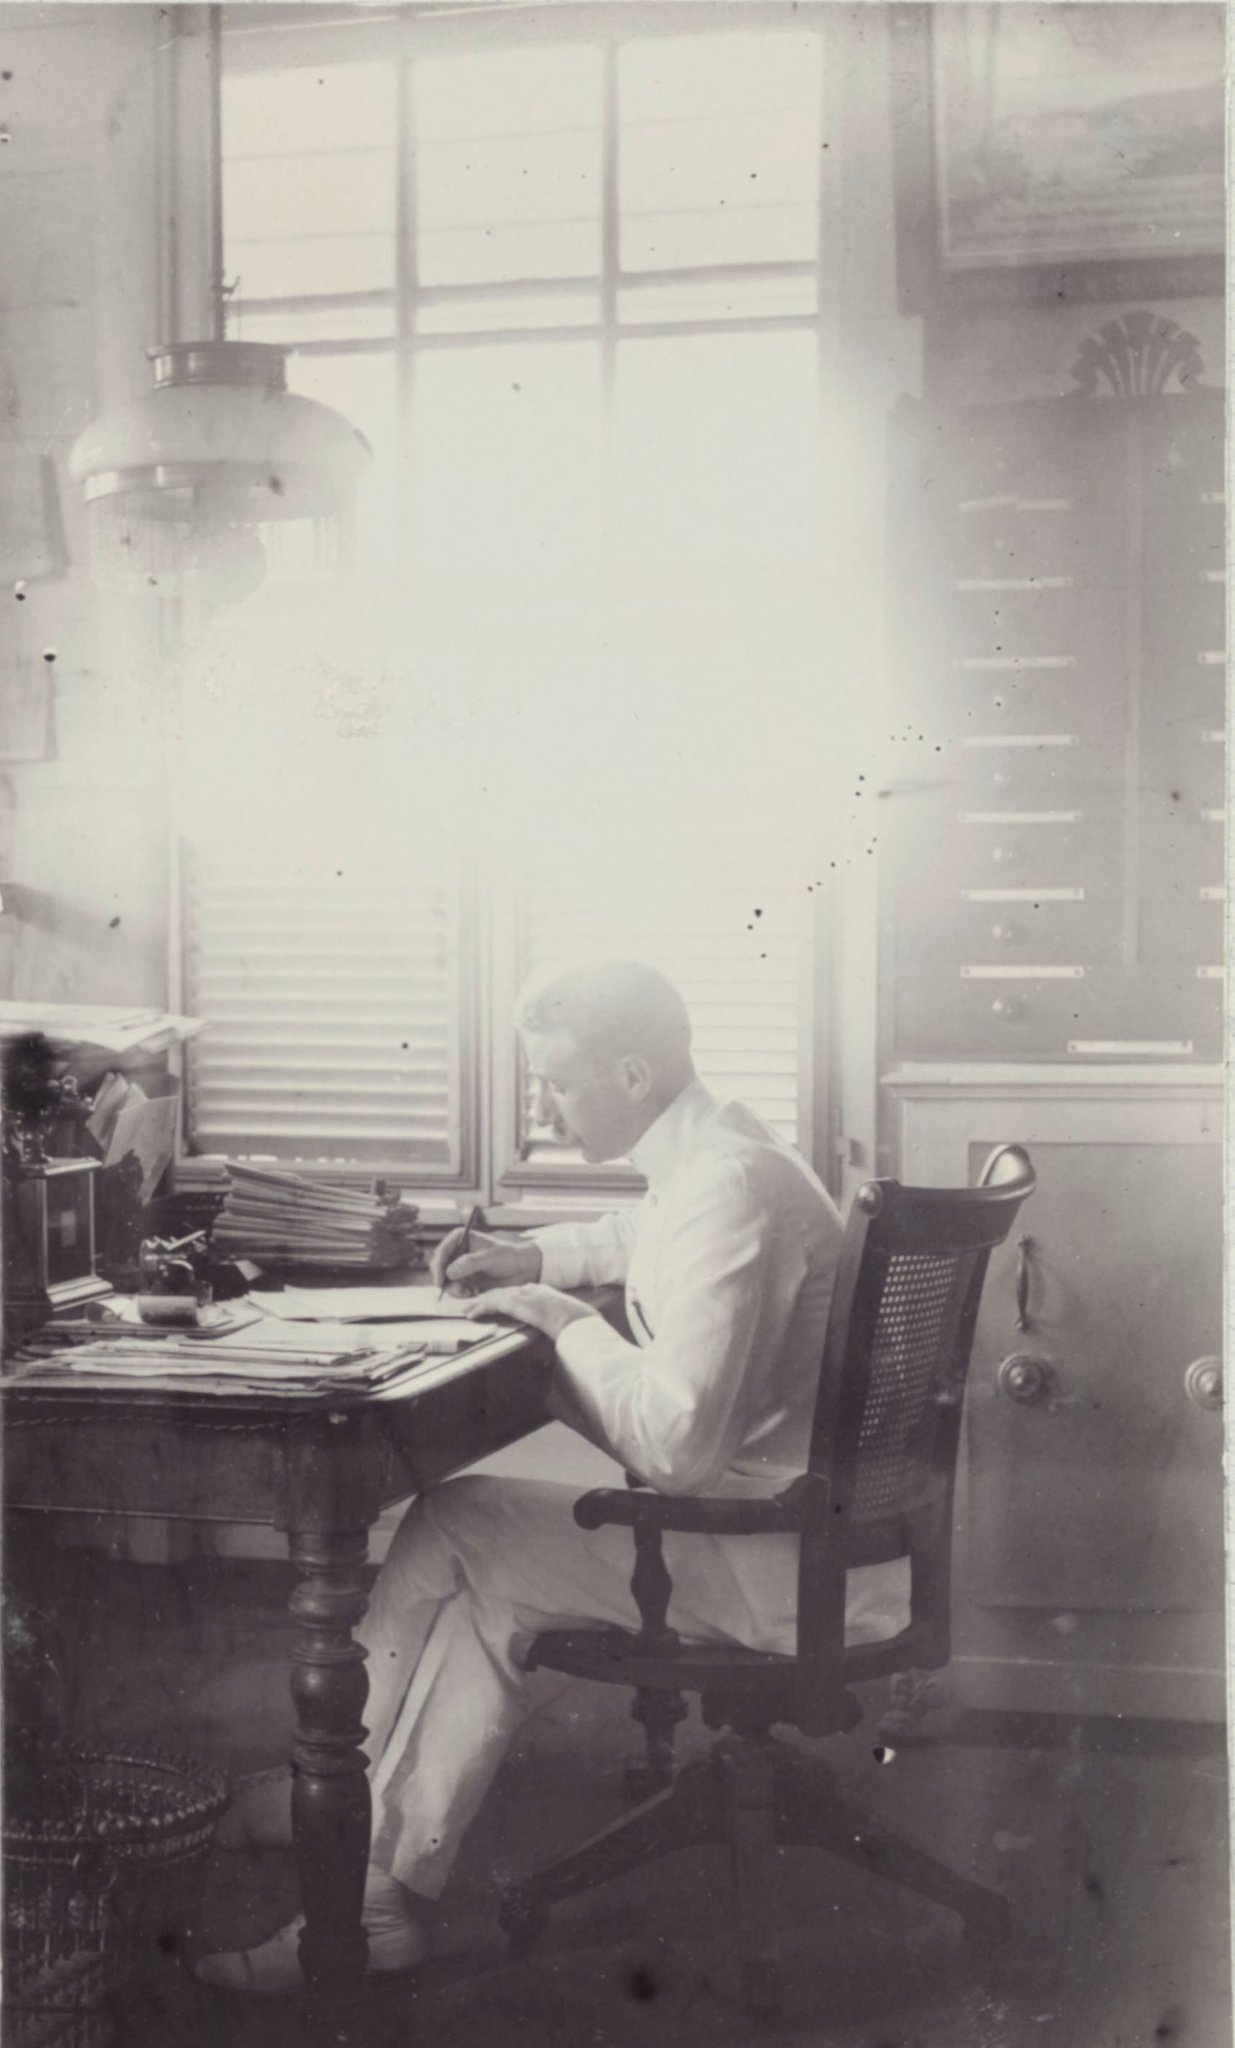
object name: photograph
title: Andries Boom op kantoor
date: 1911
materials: photographic support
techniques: photography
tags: amsterdam, andries augustus boom, administration ~ trade and finance, suriname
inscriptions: inscription: ‘Private office van den Agent v/d K.W.I.M. te Paramaribo Nov. 1911’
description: Andries Boom aan het werk op het kantoor van de K.W.I.M. te Paramaribo, november 1911. Onderdeel van het fotoalbum van de familie Boom-Gonggrijp in Suriname en Curaçao.